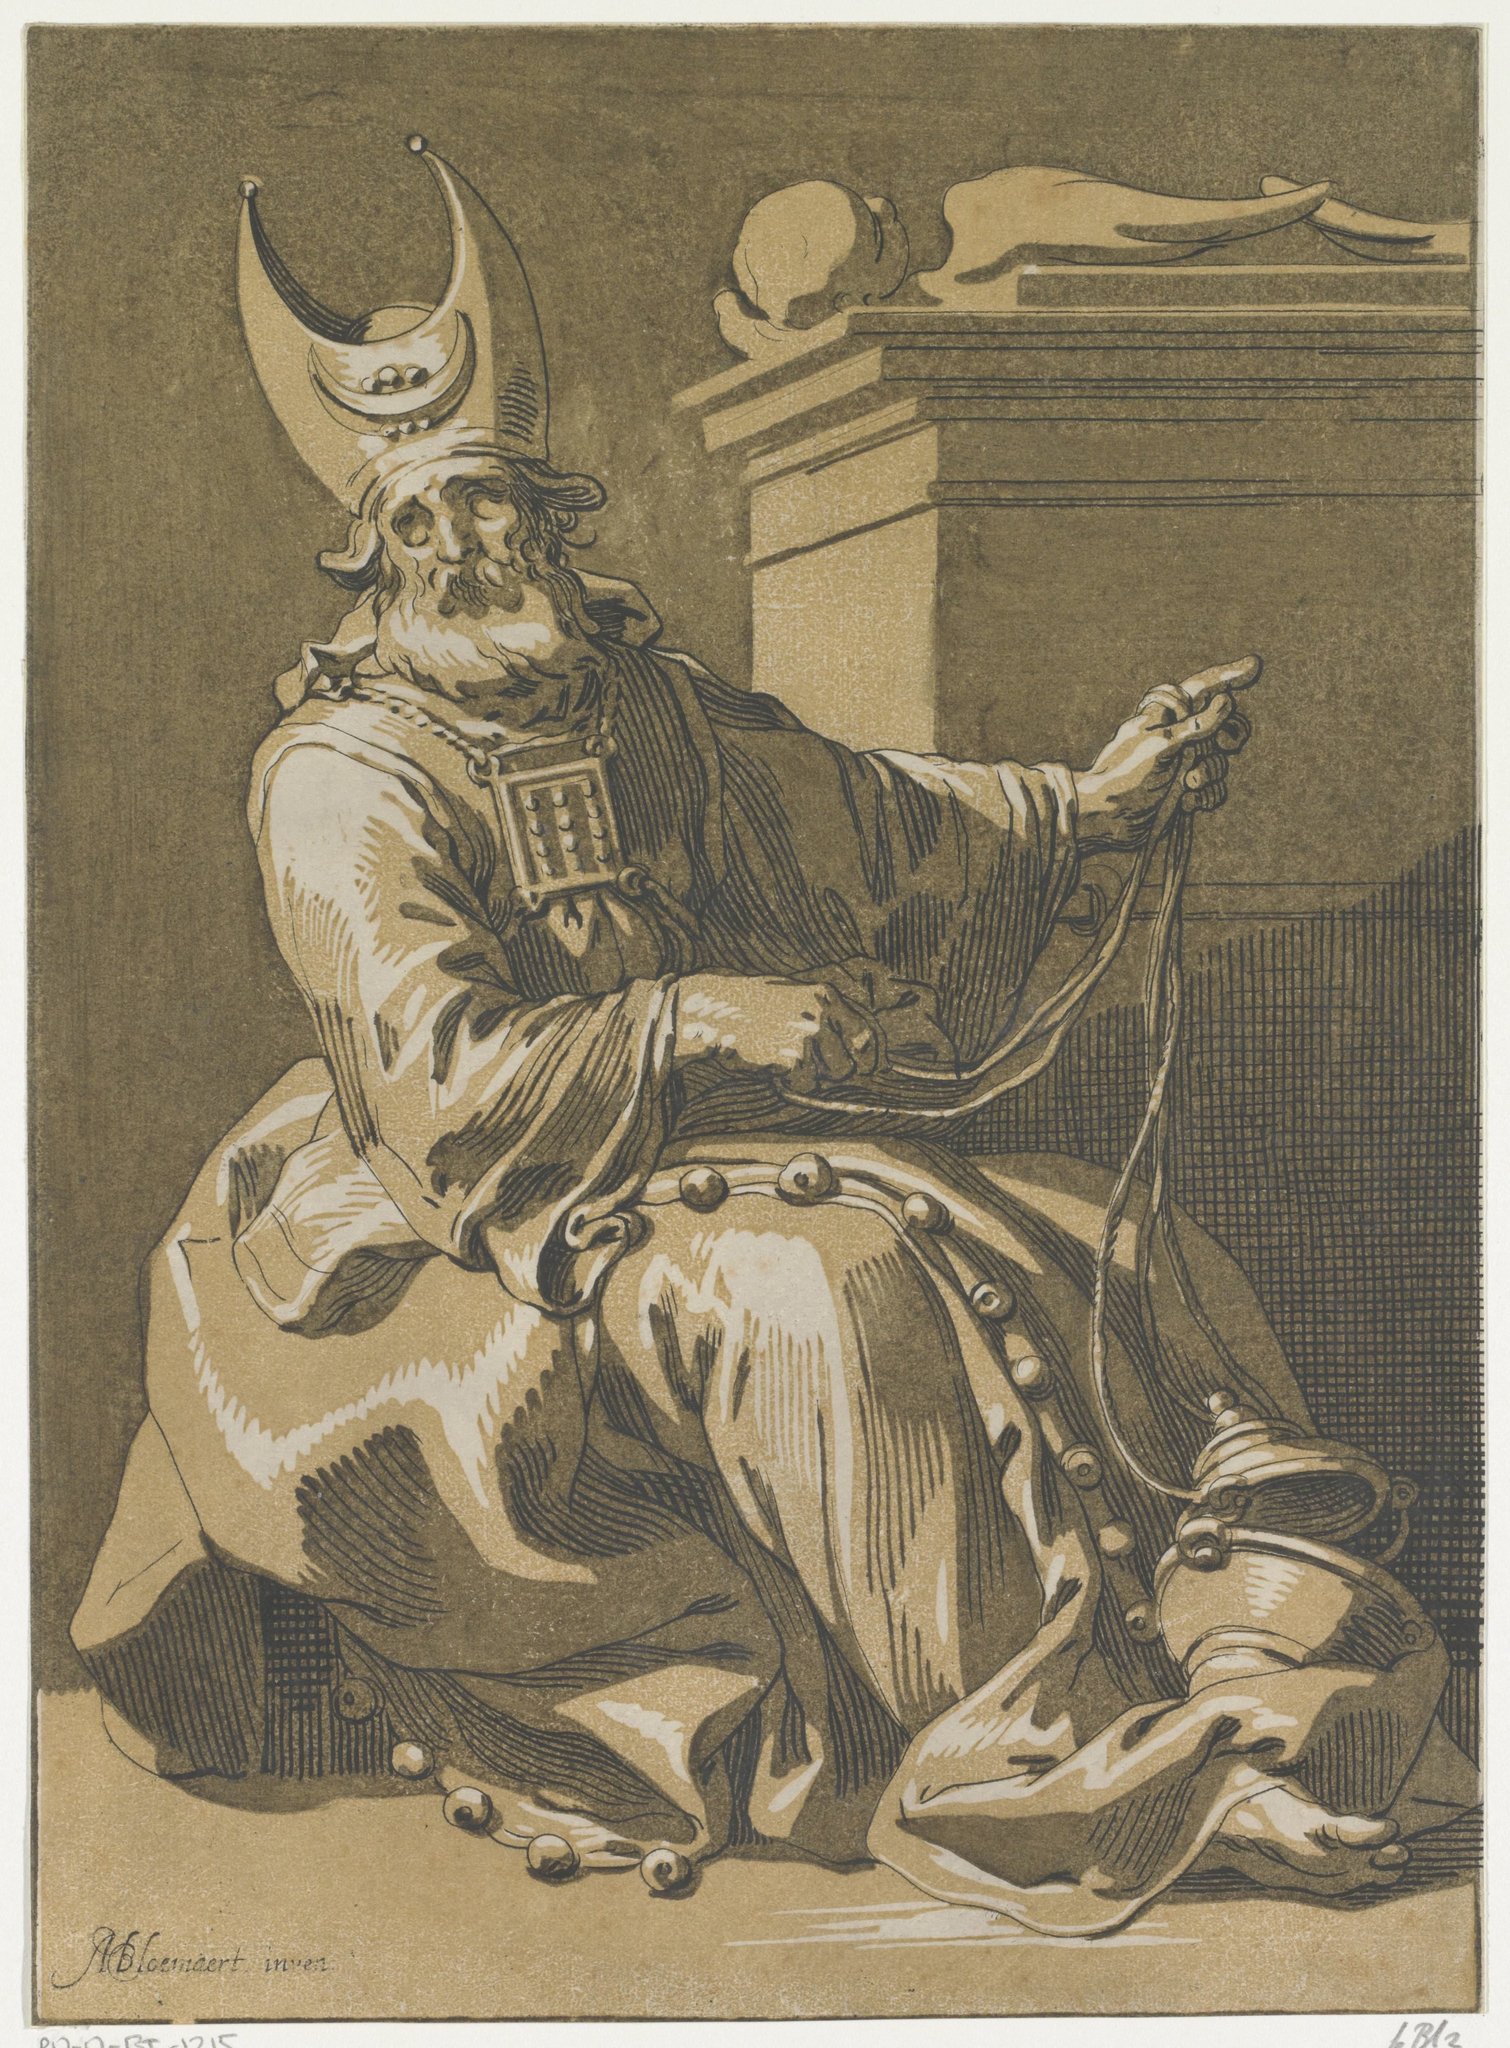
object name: print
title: Aäron zittend bij de Ark des Verbonds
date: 1610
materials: paper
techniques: woodcut, etching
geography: netherlands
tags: the tabernacle is set up and moses puts the ark with the tables in it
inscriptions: collector's mark: Lugt 240